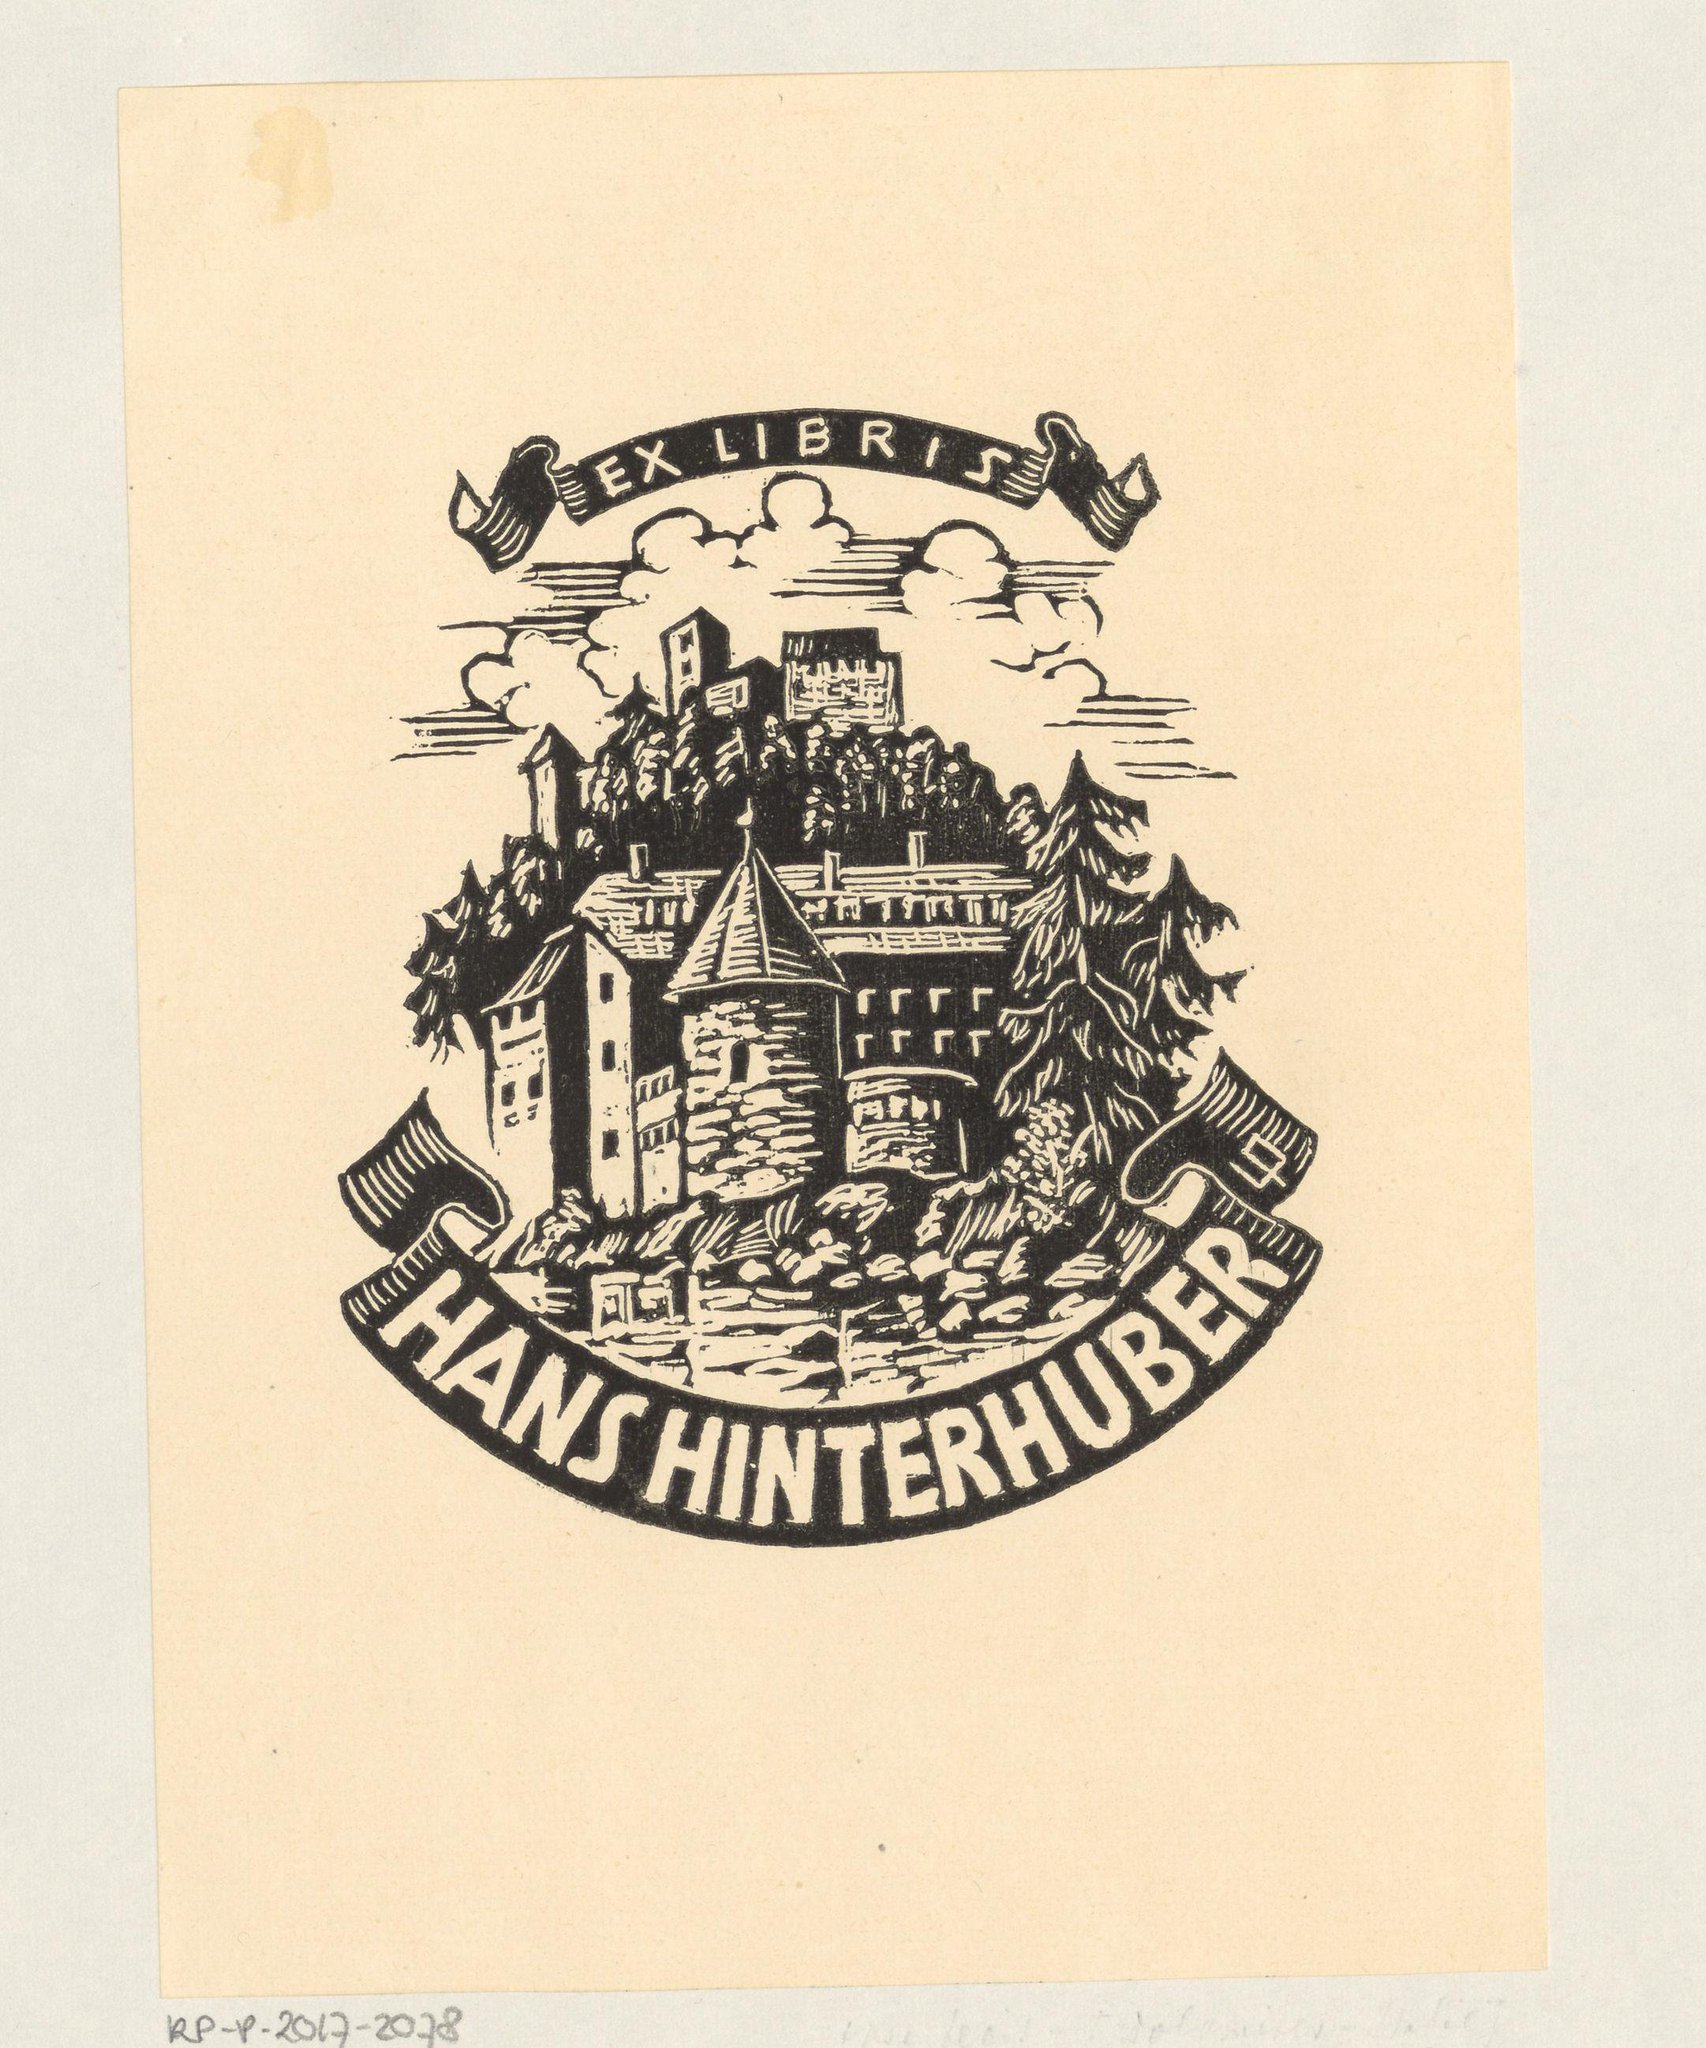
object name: bookplate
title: Ex libris van Hans Hinterhuber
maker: Anonymous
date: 1900-1999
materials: paper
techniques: linocut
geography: italy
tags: forest of coniferous trees, castle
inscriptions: inscription: ‘ipse fecit’